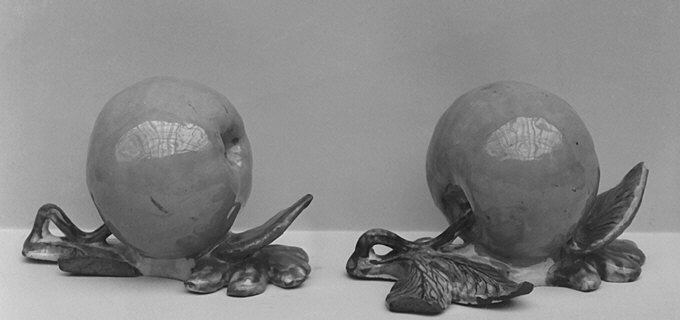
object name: figure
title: Apple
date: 1750-1775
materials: earthenware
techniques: glazing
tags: apples